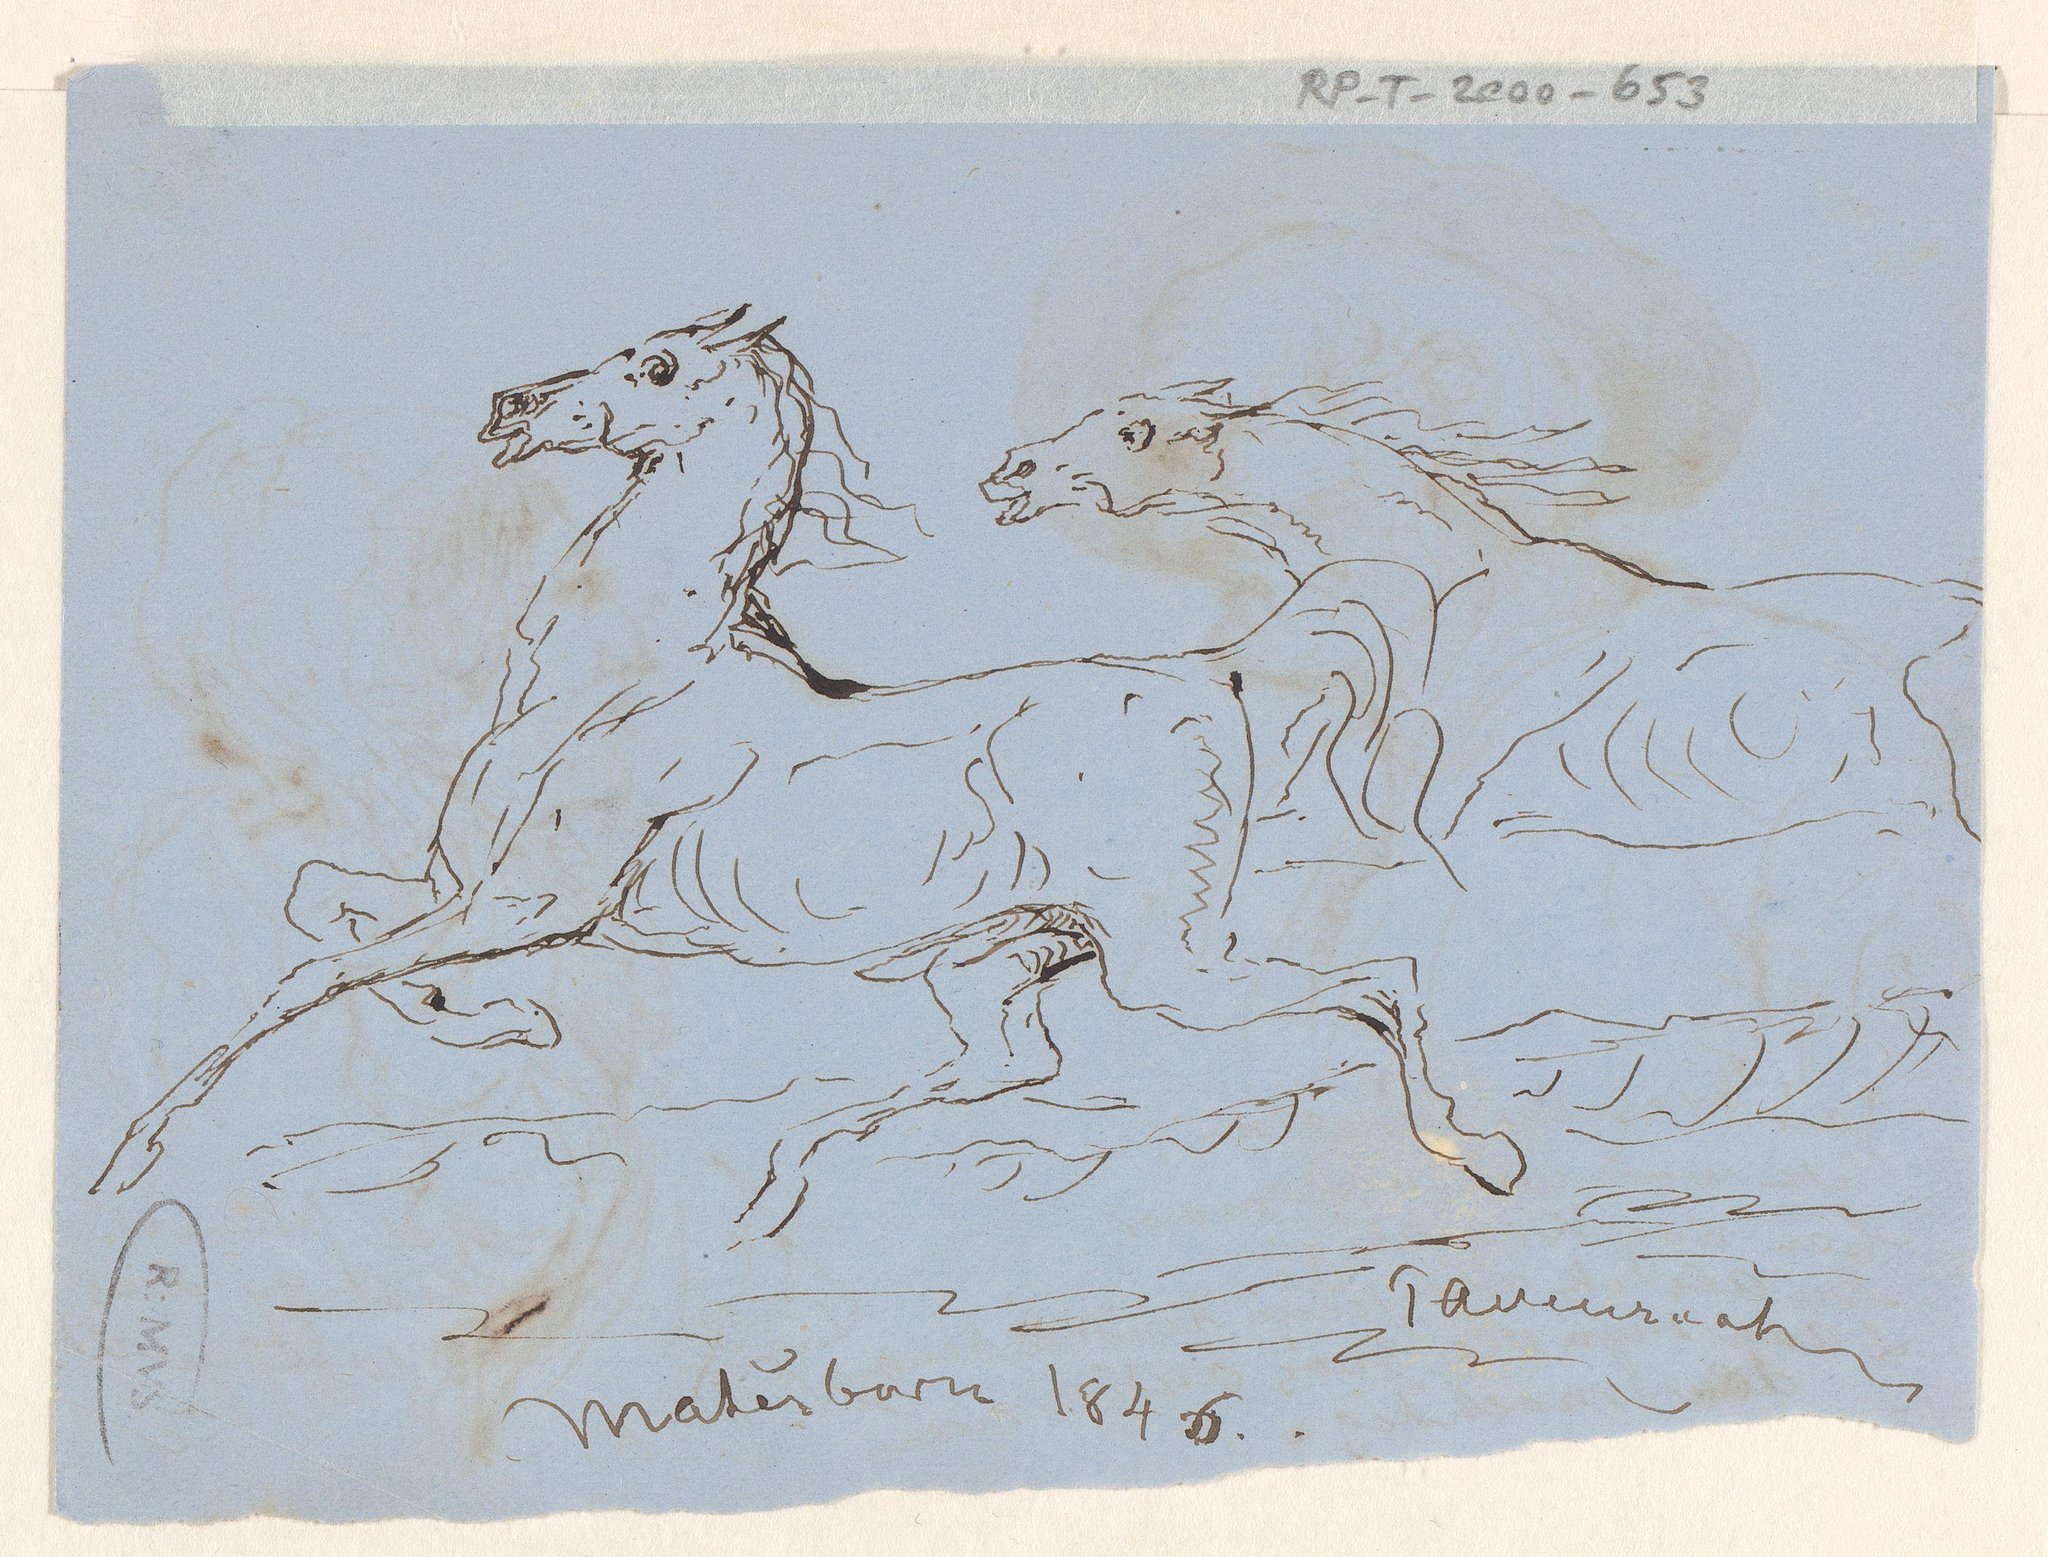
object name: drawing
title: Paarden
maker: johannes tavenraat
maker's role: draughtsman, painter, print maker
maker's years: 1809-1881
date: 1846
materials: ink, paper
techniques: pen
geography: materborn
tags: horse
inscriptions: collector's mark: Lugt 2228, signature, date and inscription: ‘Materborn 1846. Tavenraat’